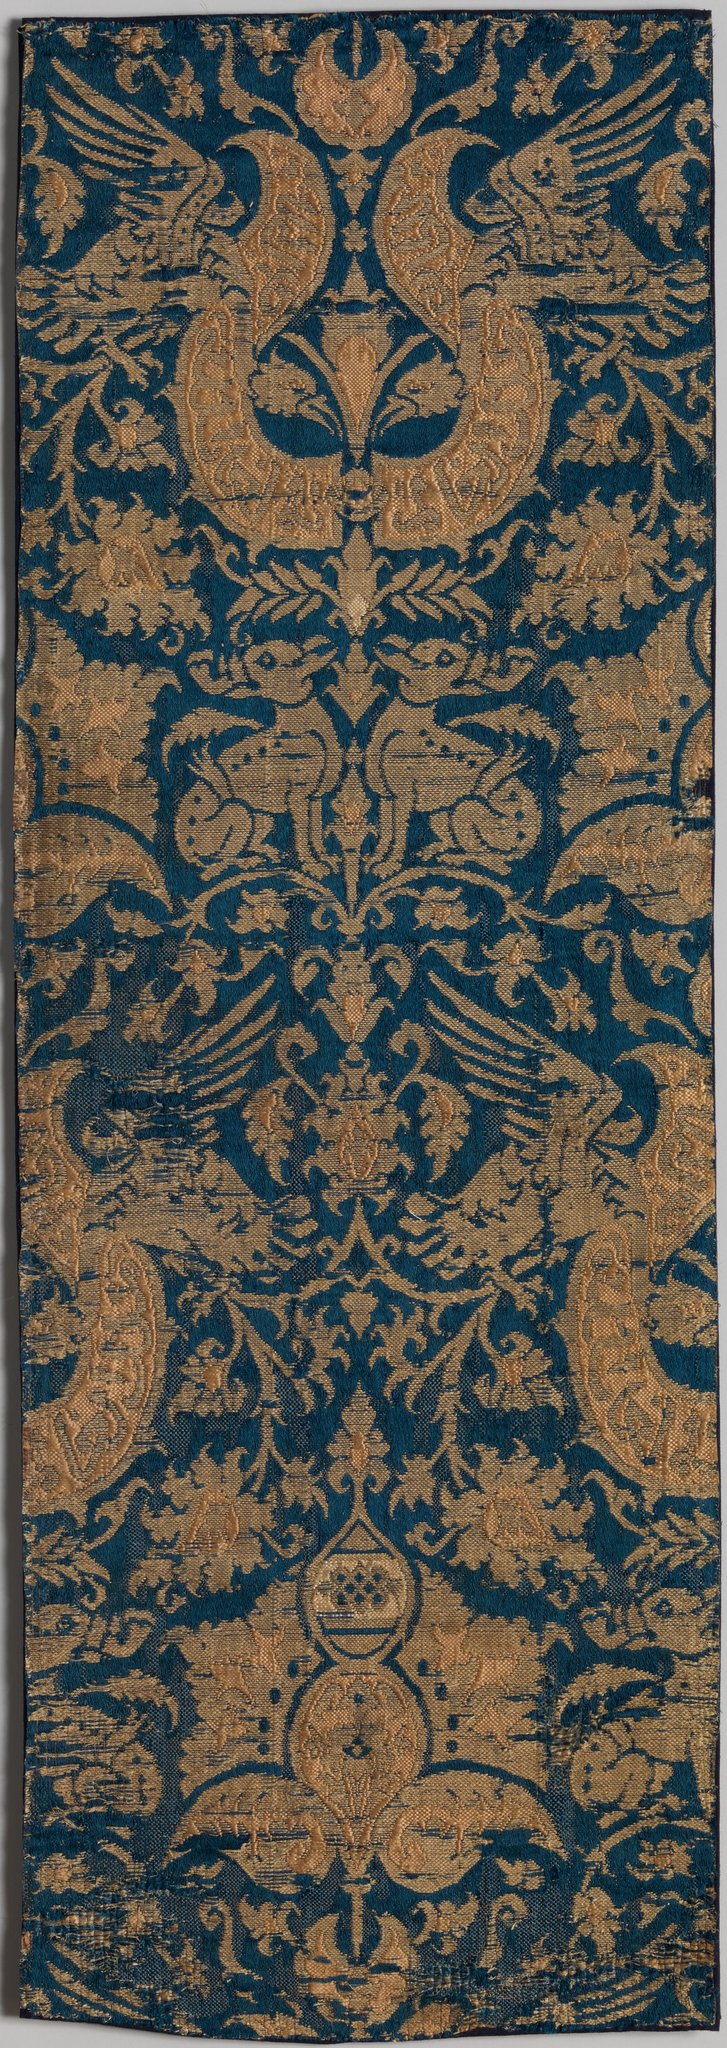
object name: textile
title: Textile with Brocade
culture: near eastern or spanish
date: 1301-1500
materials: metal thread, textile, silk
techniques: weave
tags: mythical creatures